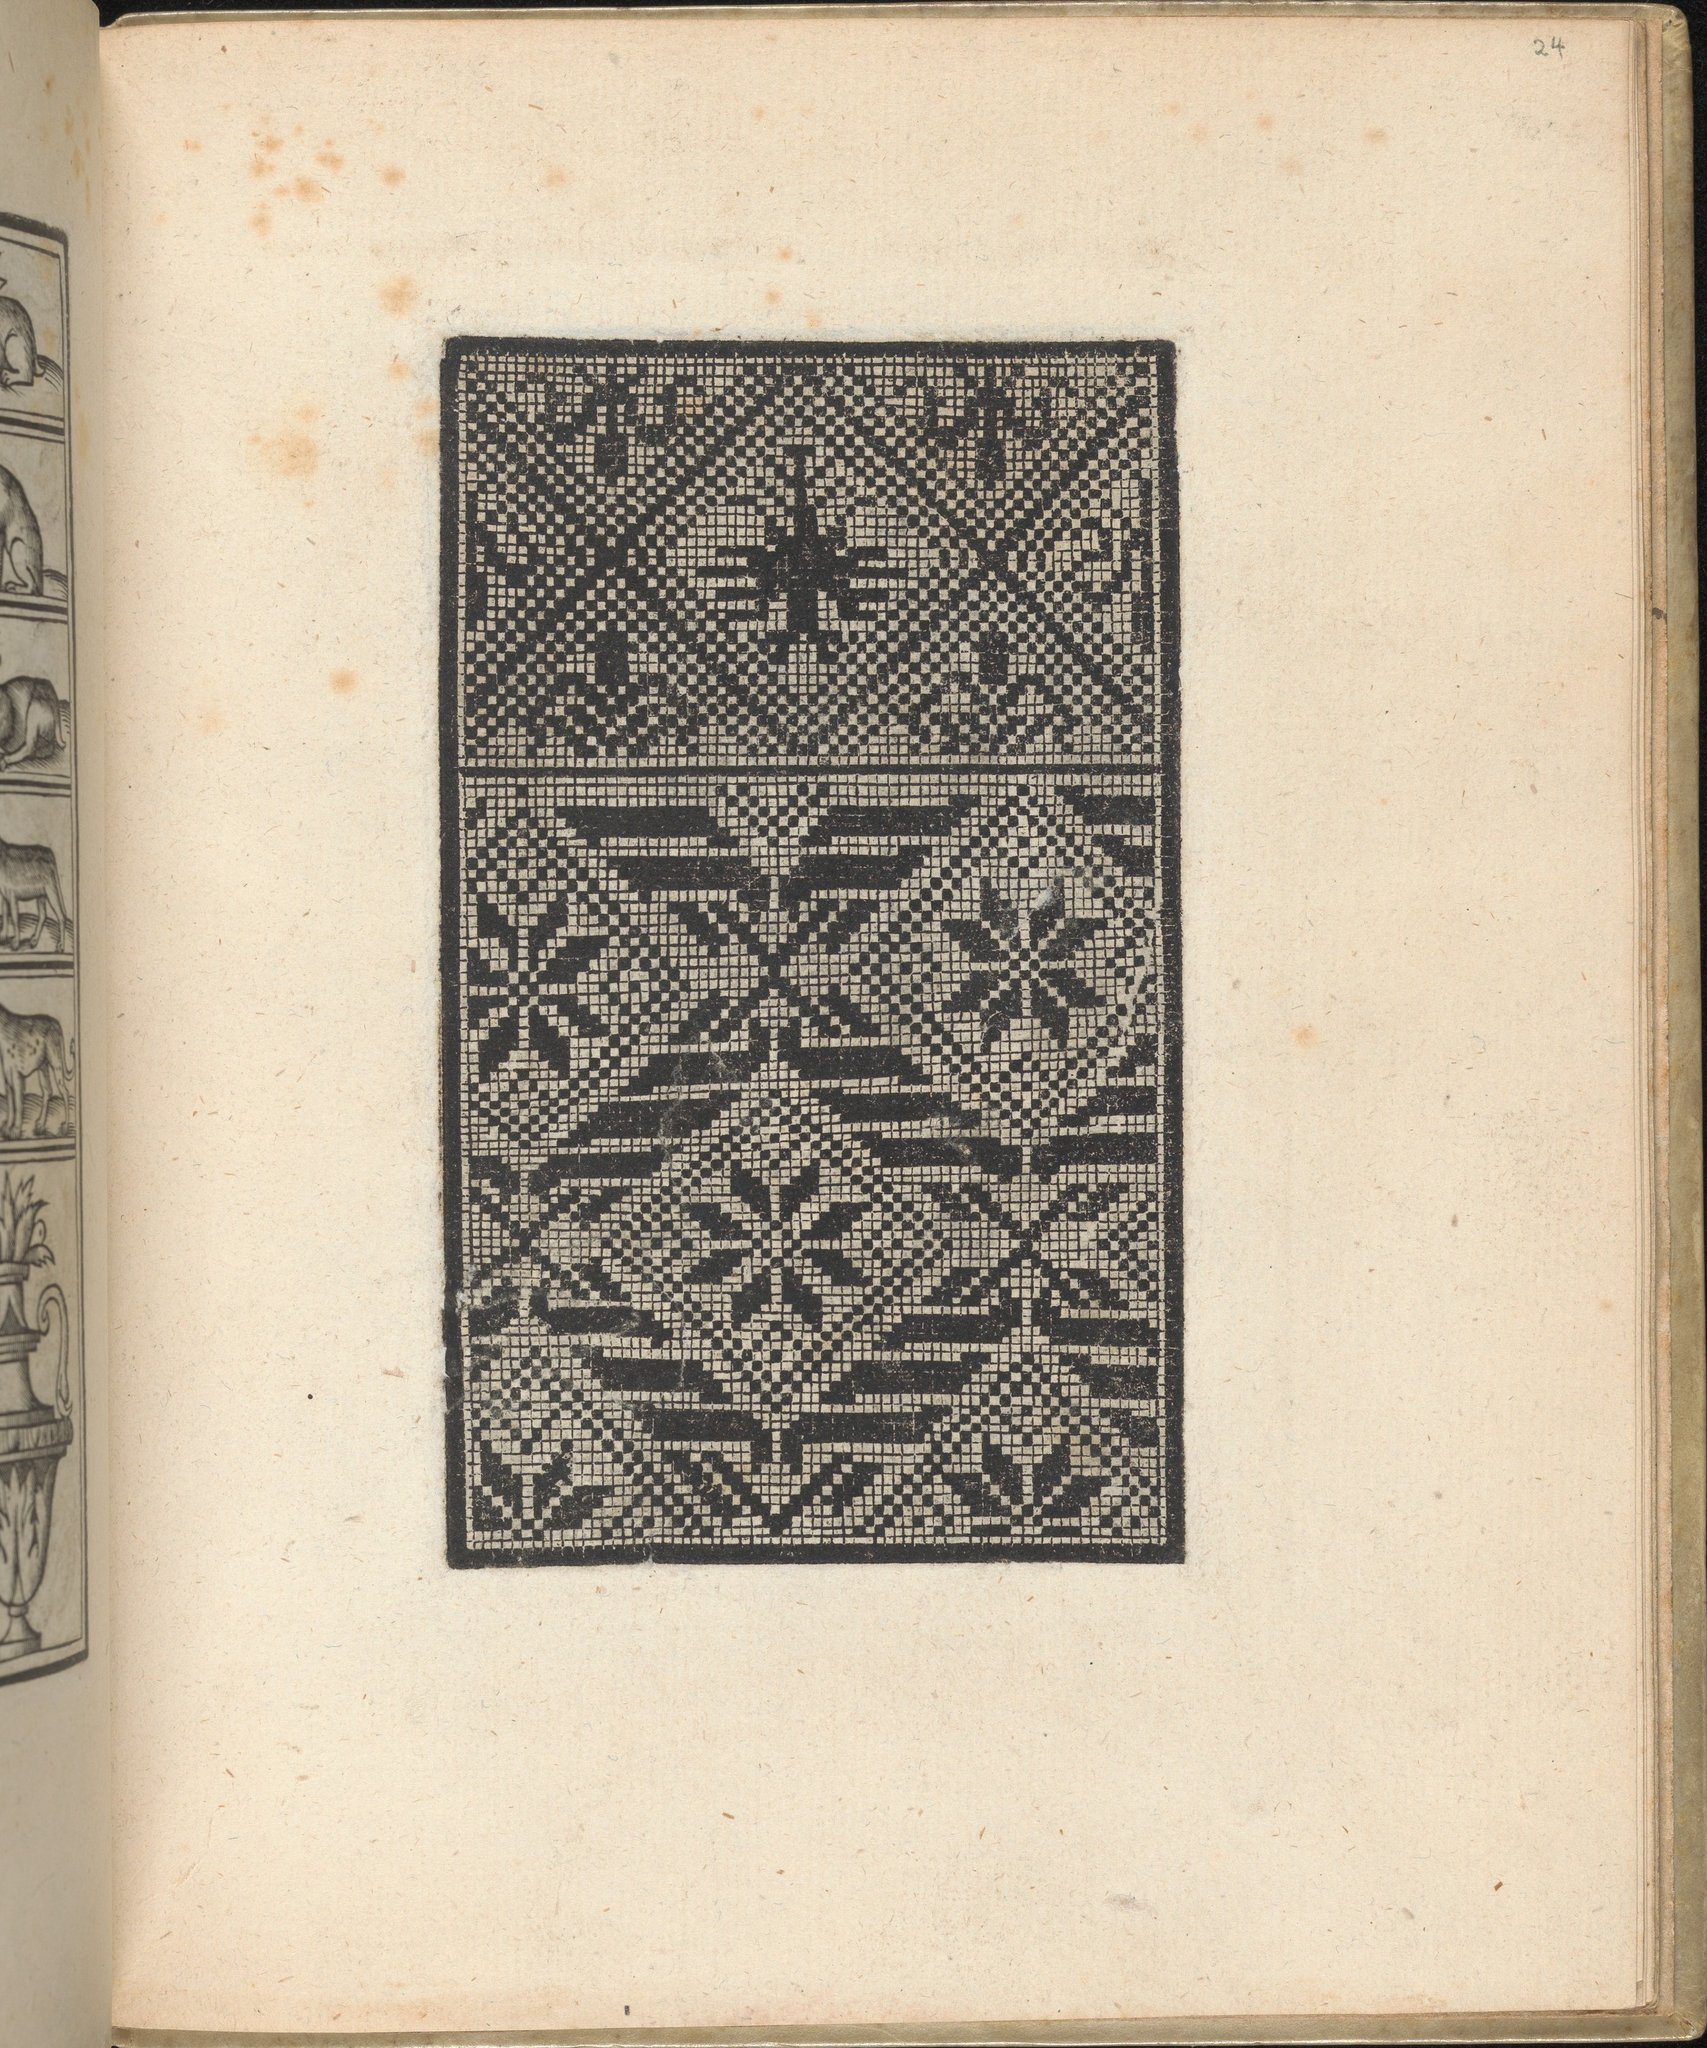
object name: book print ornament architecture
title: Trionfo Di Virtu. Libro Novo..., page 24 (verso)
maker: matteo pagano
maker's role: publisher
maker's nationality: italian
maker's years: 1515-1588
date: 1563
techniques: woodcut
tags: ornament